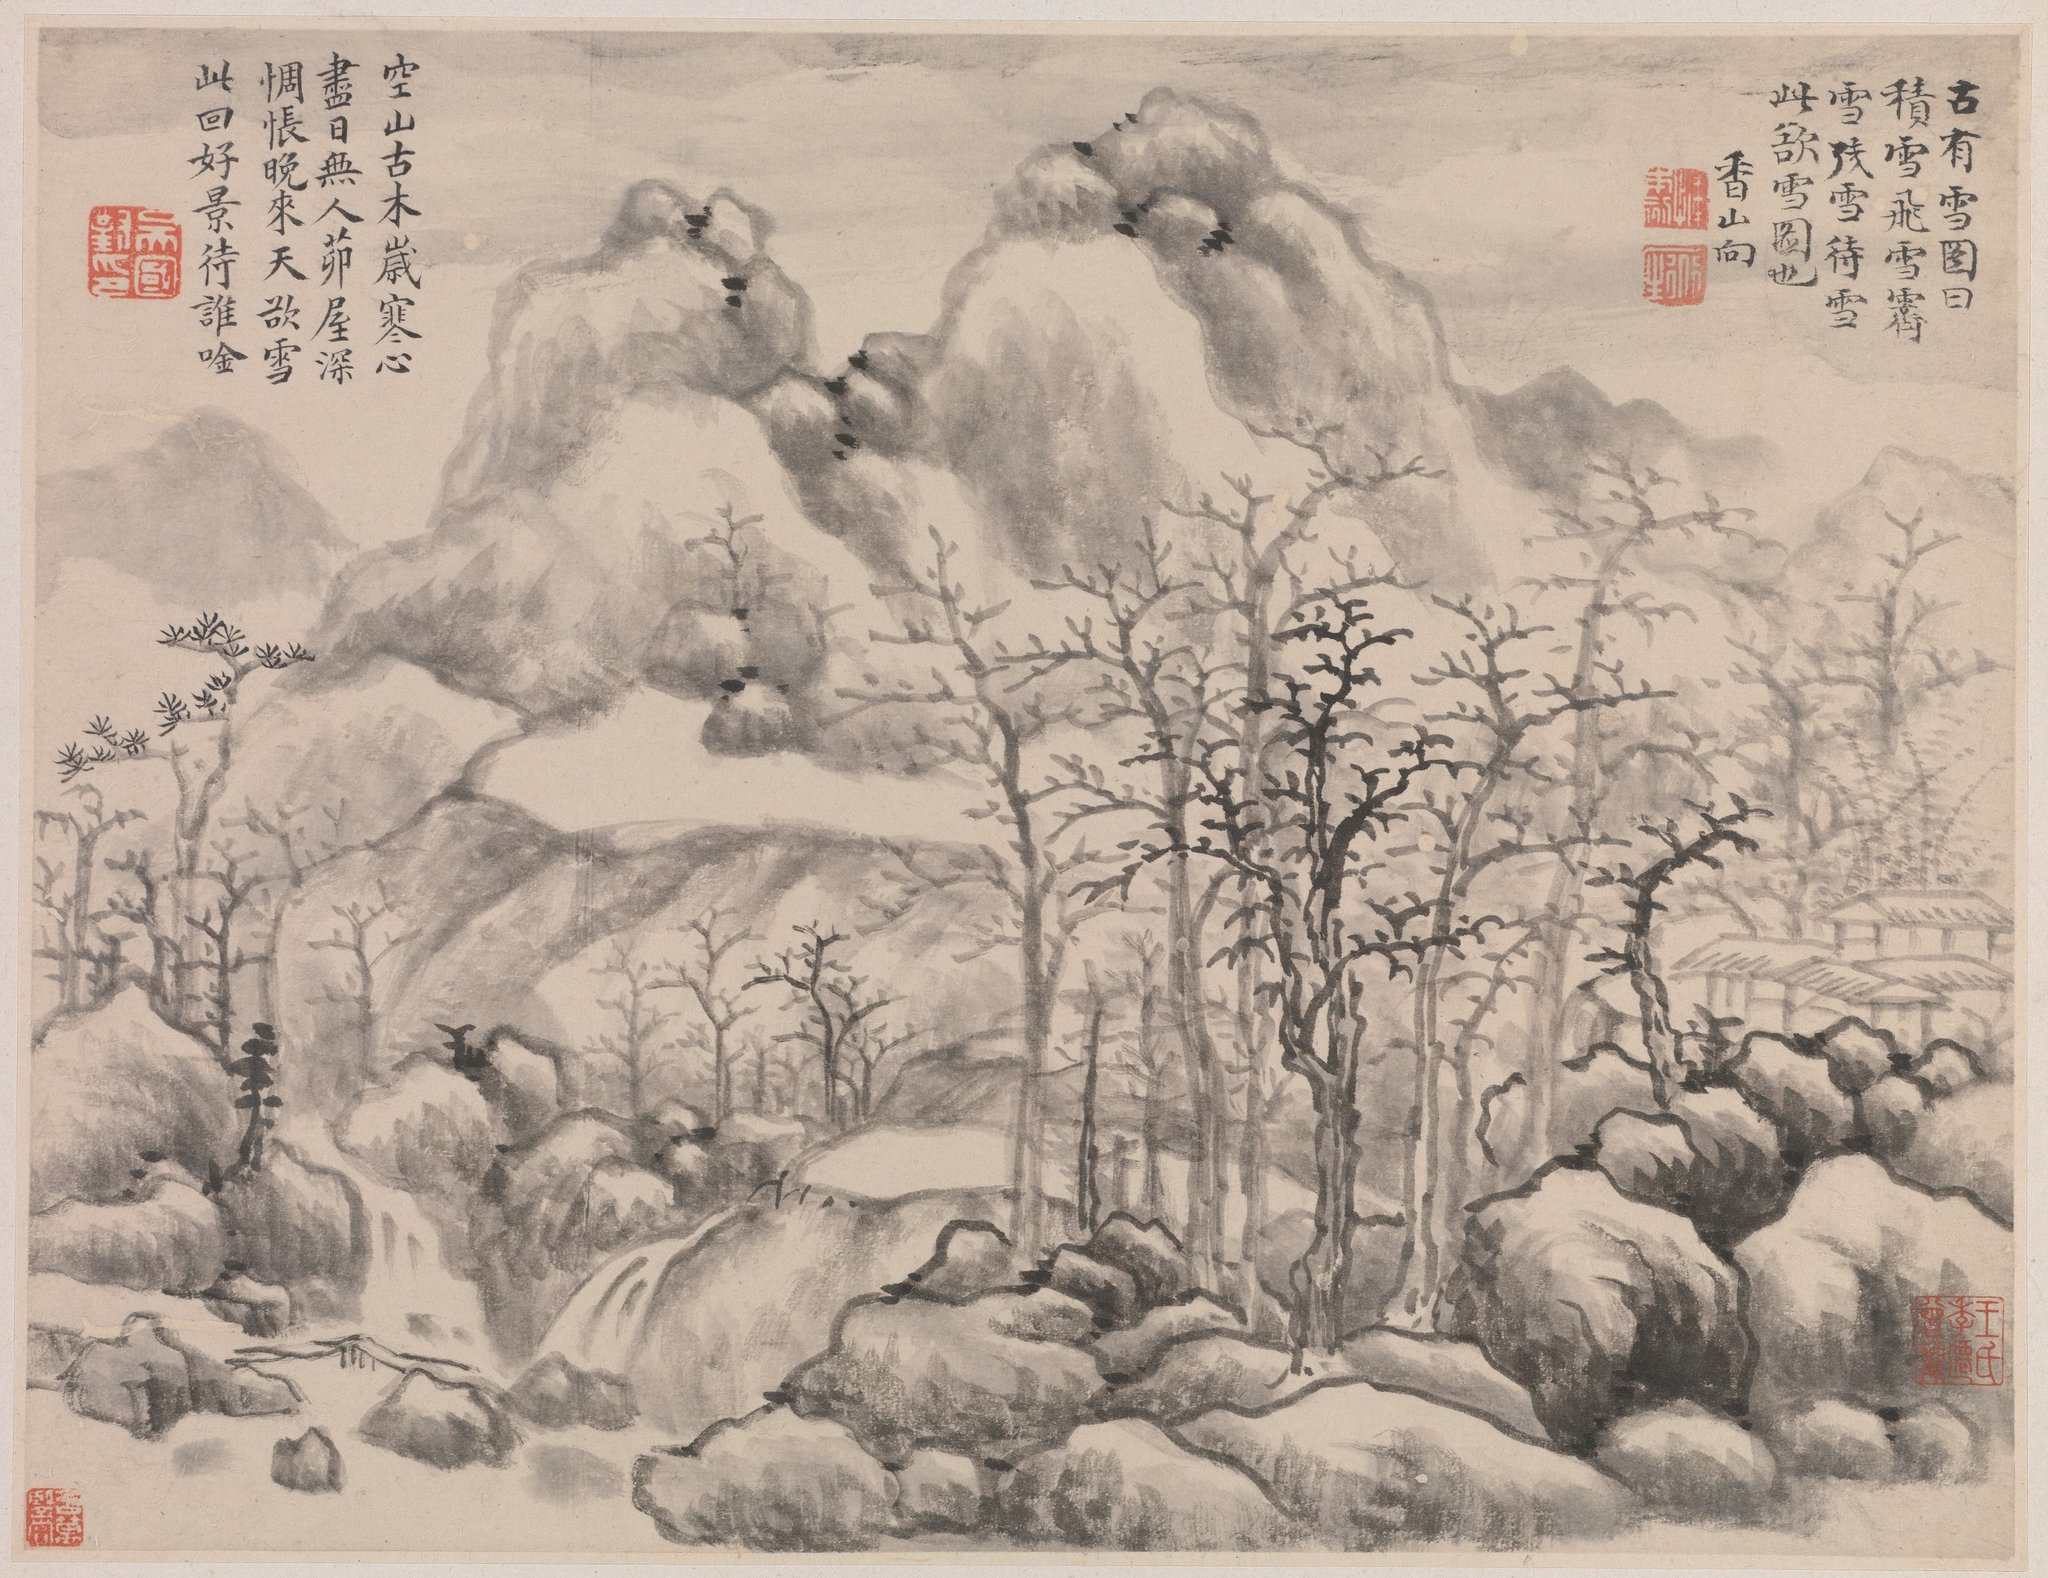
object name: album leaf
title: Snowscape, from Album for Zhou Lianggong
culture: chinese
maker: yun xiang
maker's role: artist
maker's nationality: chinese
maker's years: 1586-1655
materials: ink, paper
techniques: calligraphy, painting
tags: mountains,landscapes